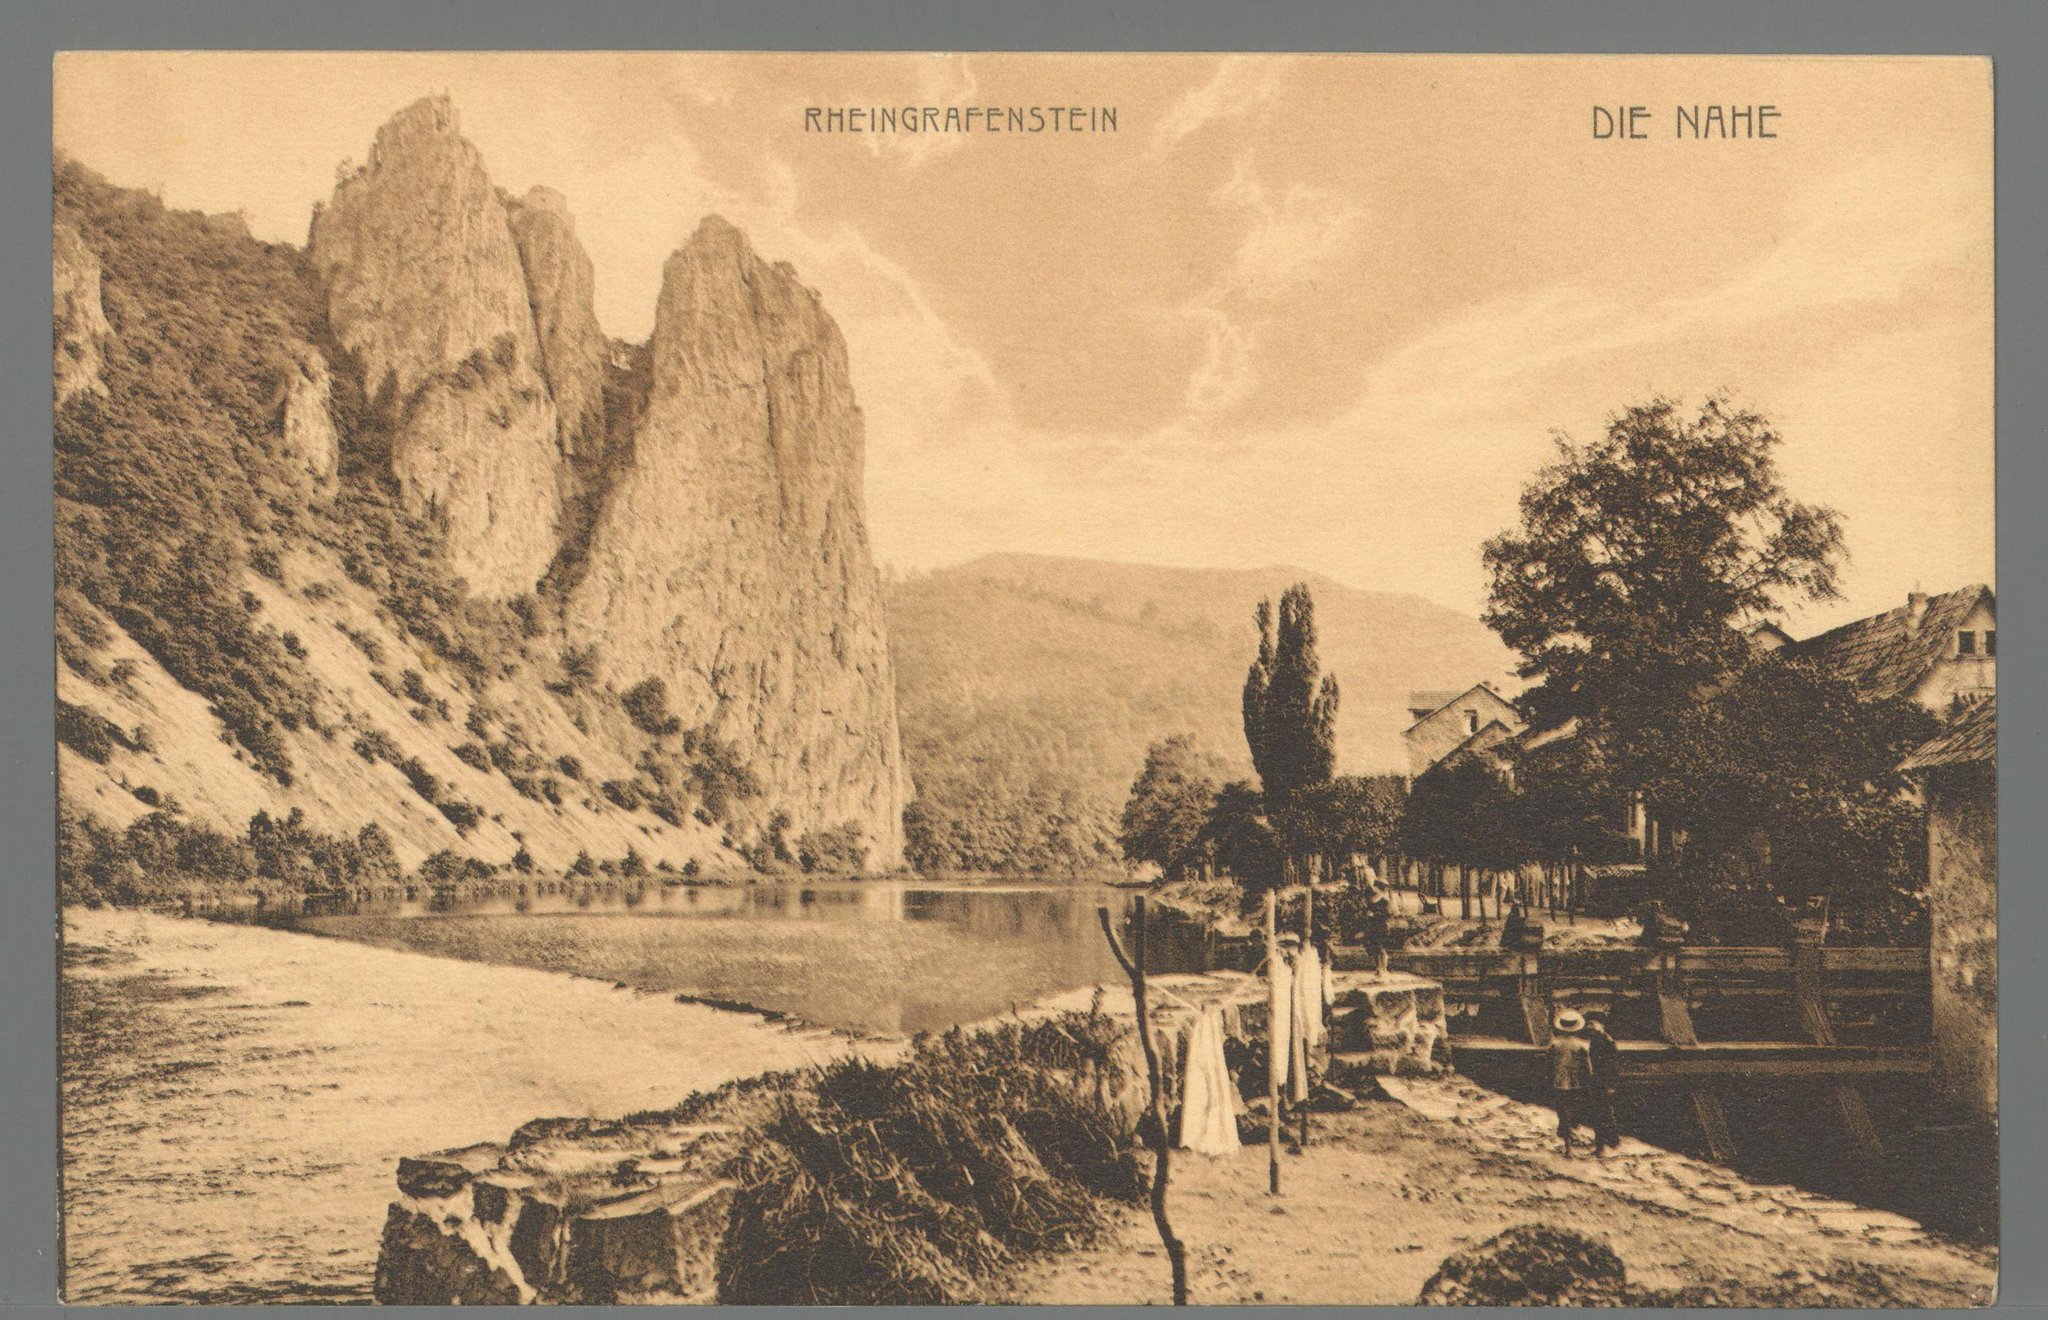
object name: photomechanical print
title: Rheingrafenstein. Die Nahe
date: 1907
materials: cardboard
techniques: photograph, writing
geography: mainz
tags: canals, waters (in city), rocks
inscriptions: date